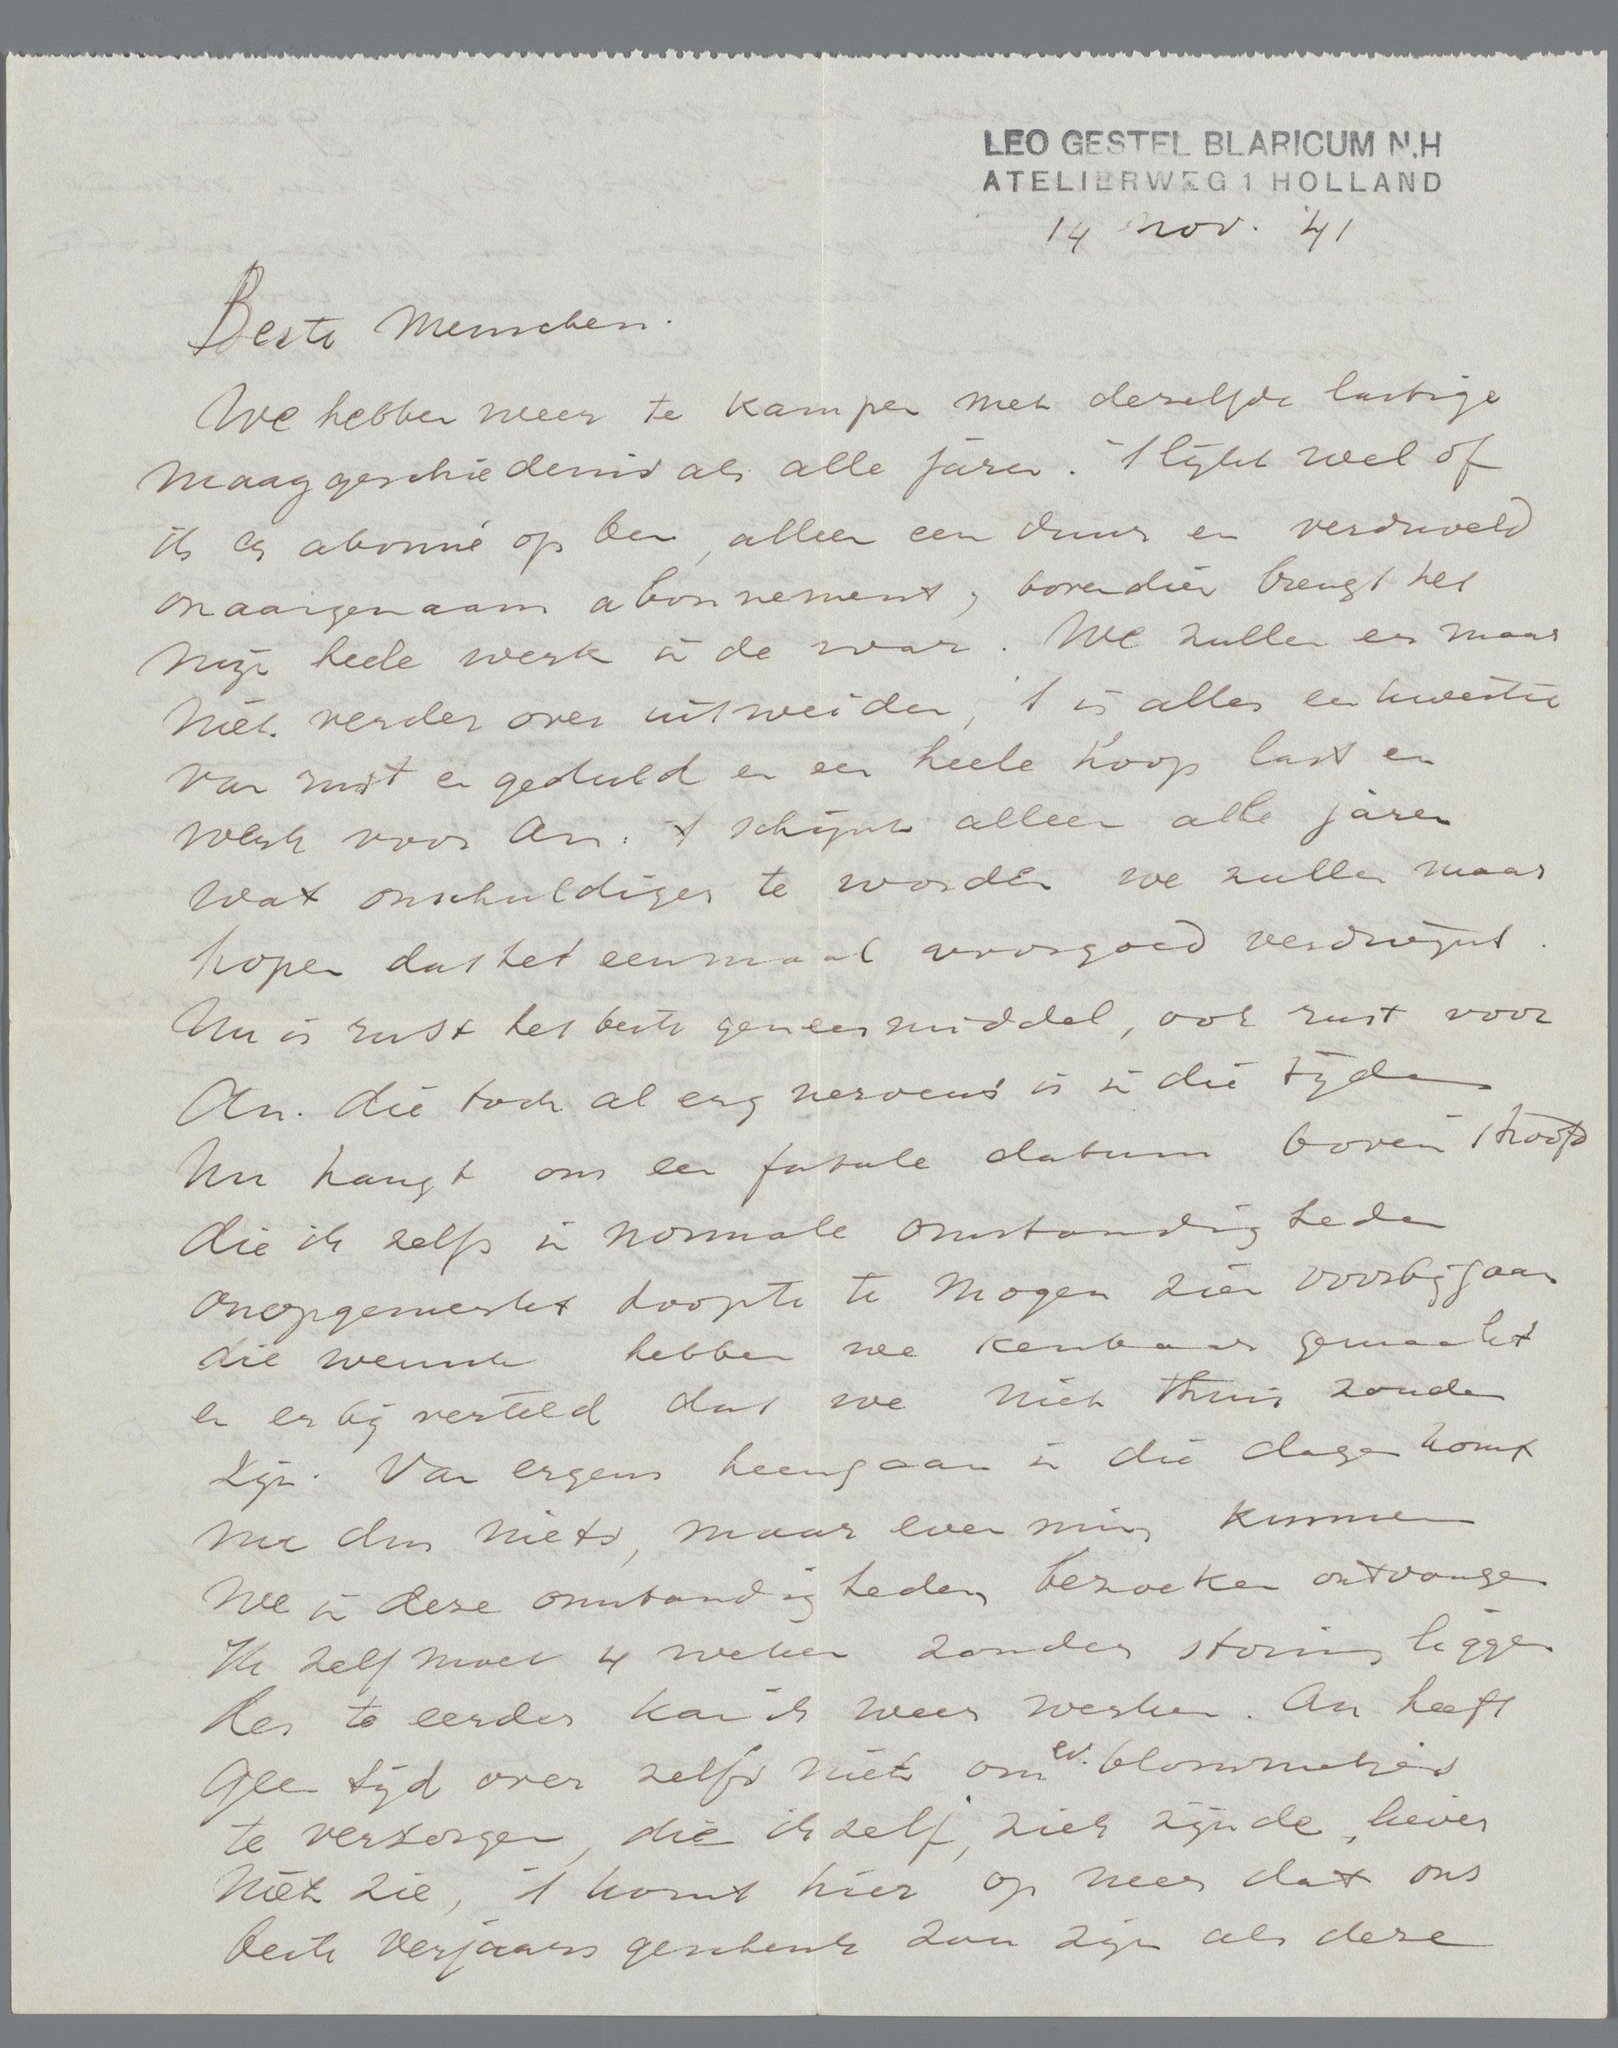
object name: letter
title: Brief aan Jan Ponstijn en Henriëtte Johanna Petronella van Hilten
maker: leo gestel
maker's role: draughtsman, print maker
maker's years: 1881-1941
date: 1941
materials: ink, paper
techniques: pen, writing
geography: blaricum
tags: henriëtte johanna petronella ponstijn-van hilten, gerrit van blaaderen, amsterdam, print maker, draughtsman, jan petrus ponstijn, painter, gerritje gestel-overtoom, patient, sick person, exhibition ~ art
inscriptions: workshop stamp: ‘LEO GESTEL BLARICUM N.H./ ATELIERWEG 1 HOLLAND’